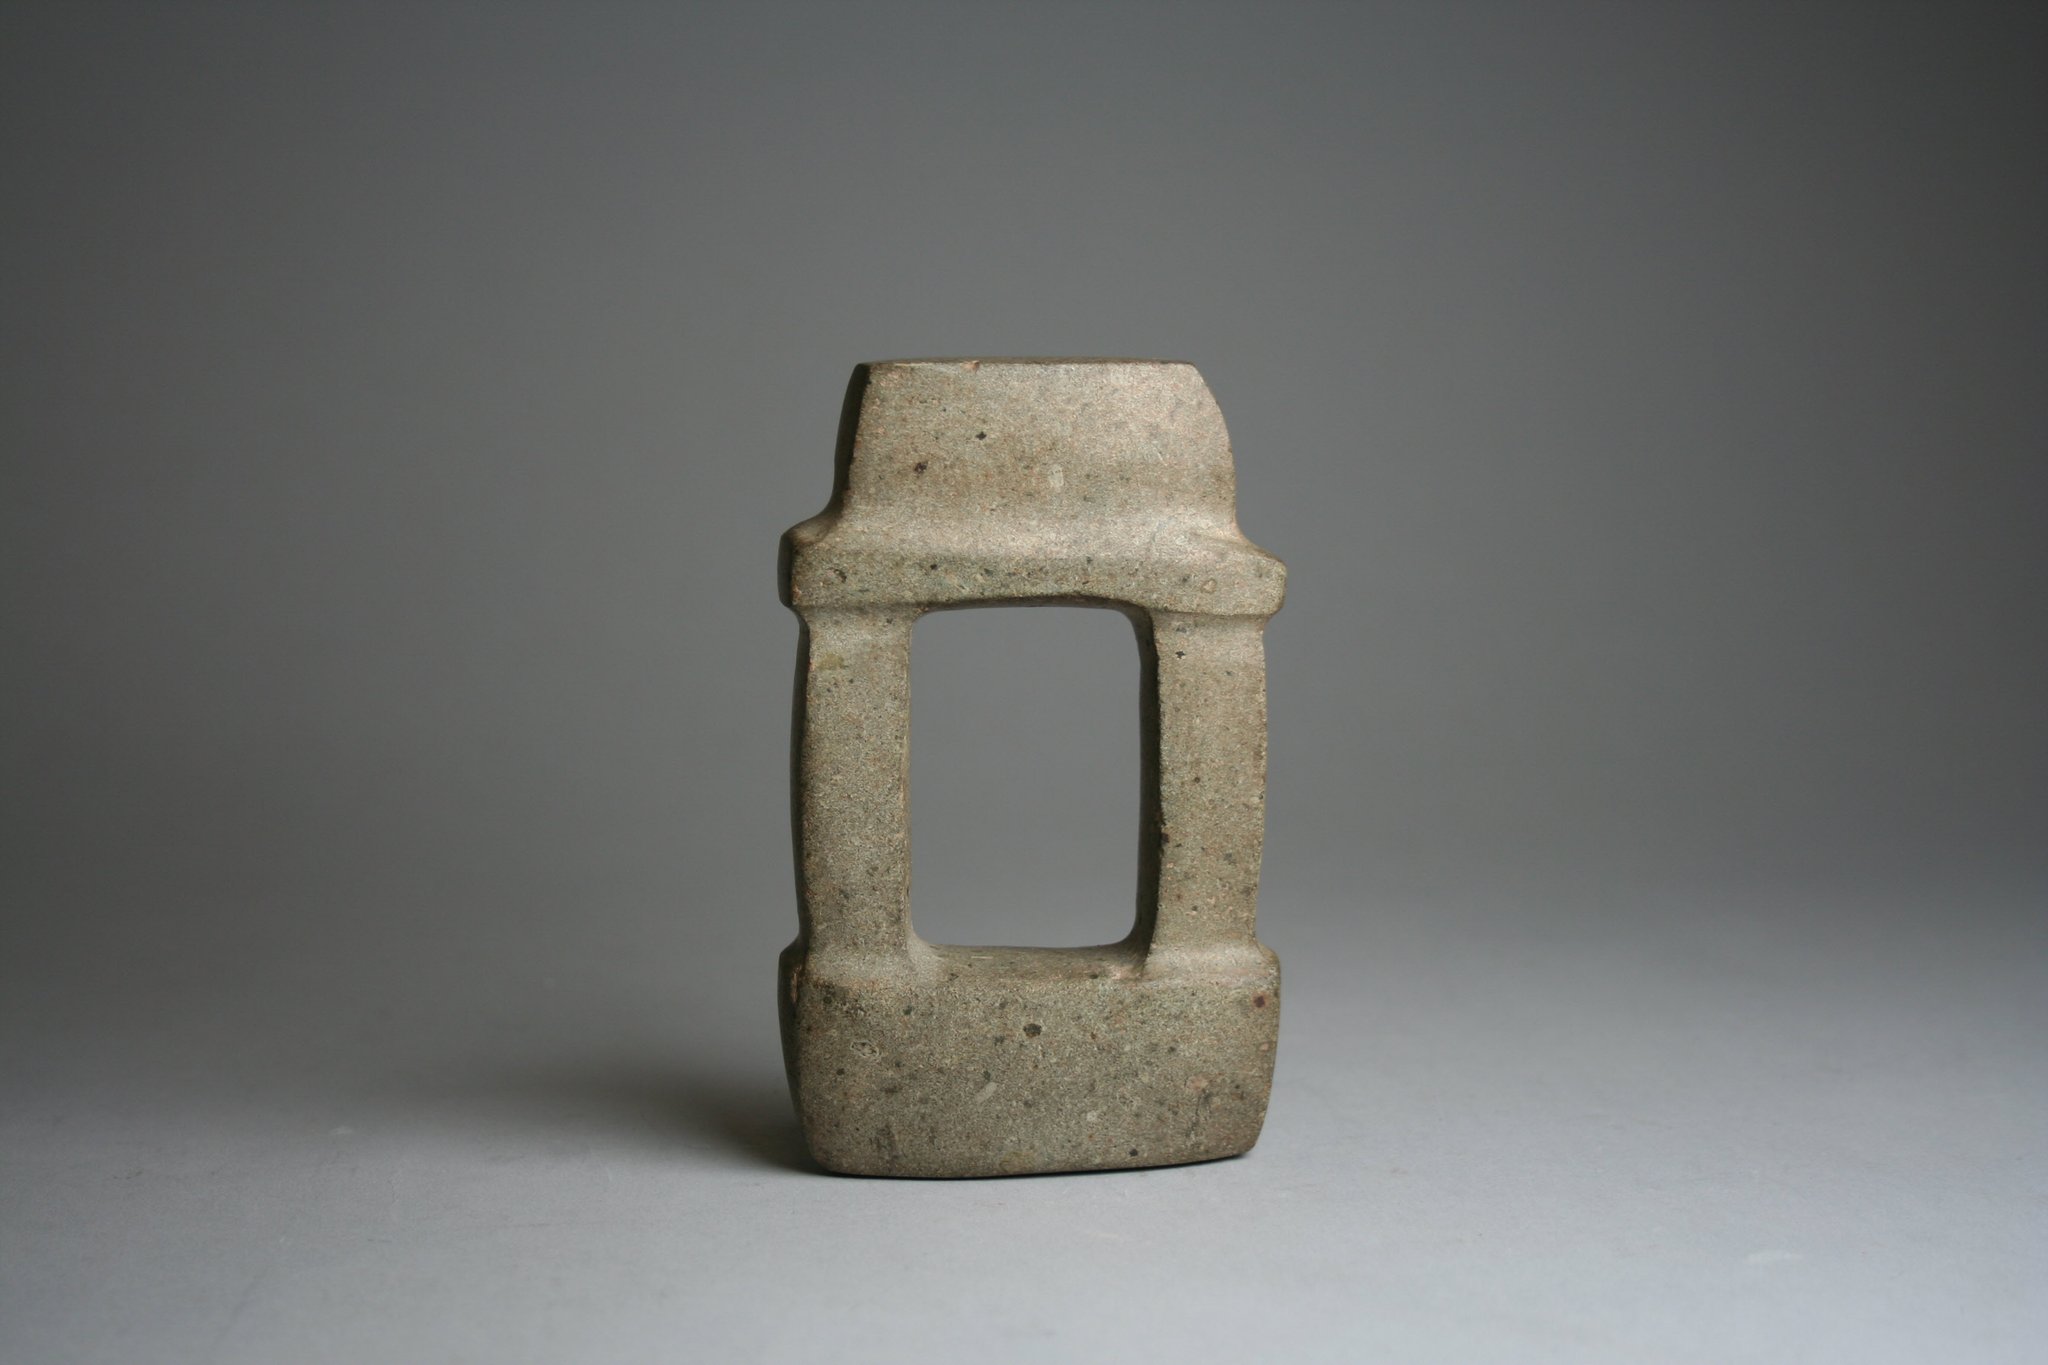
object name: architectural model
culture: mezcala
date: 1-800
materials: stone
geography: mexico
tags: temples